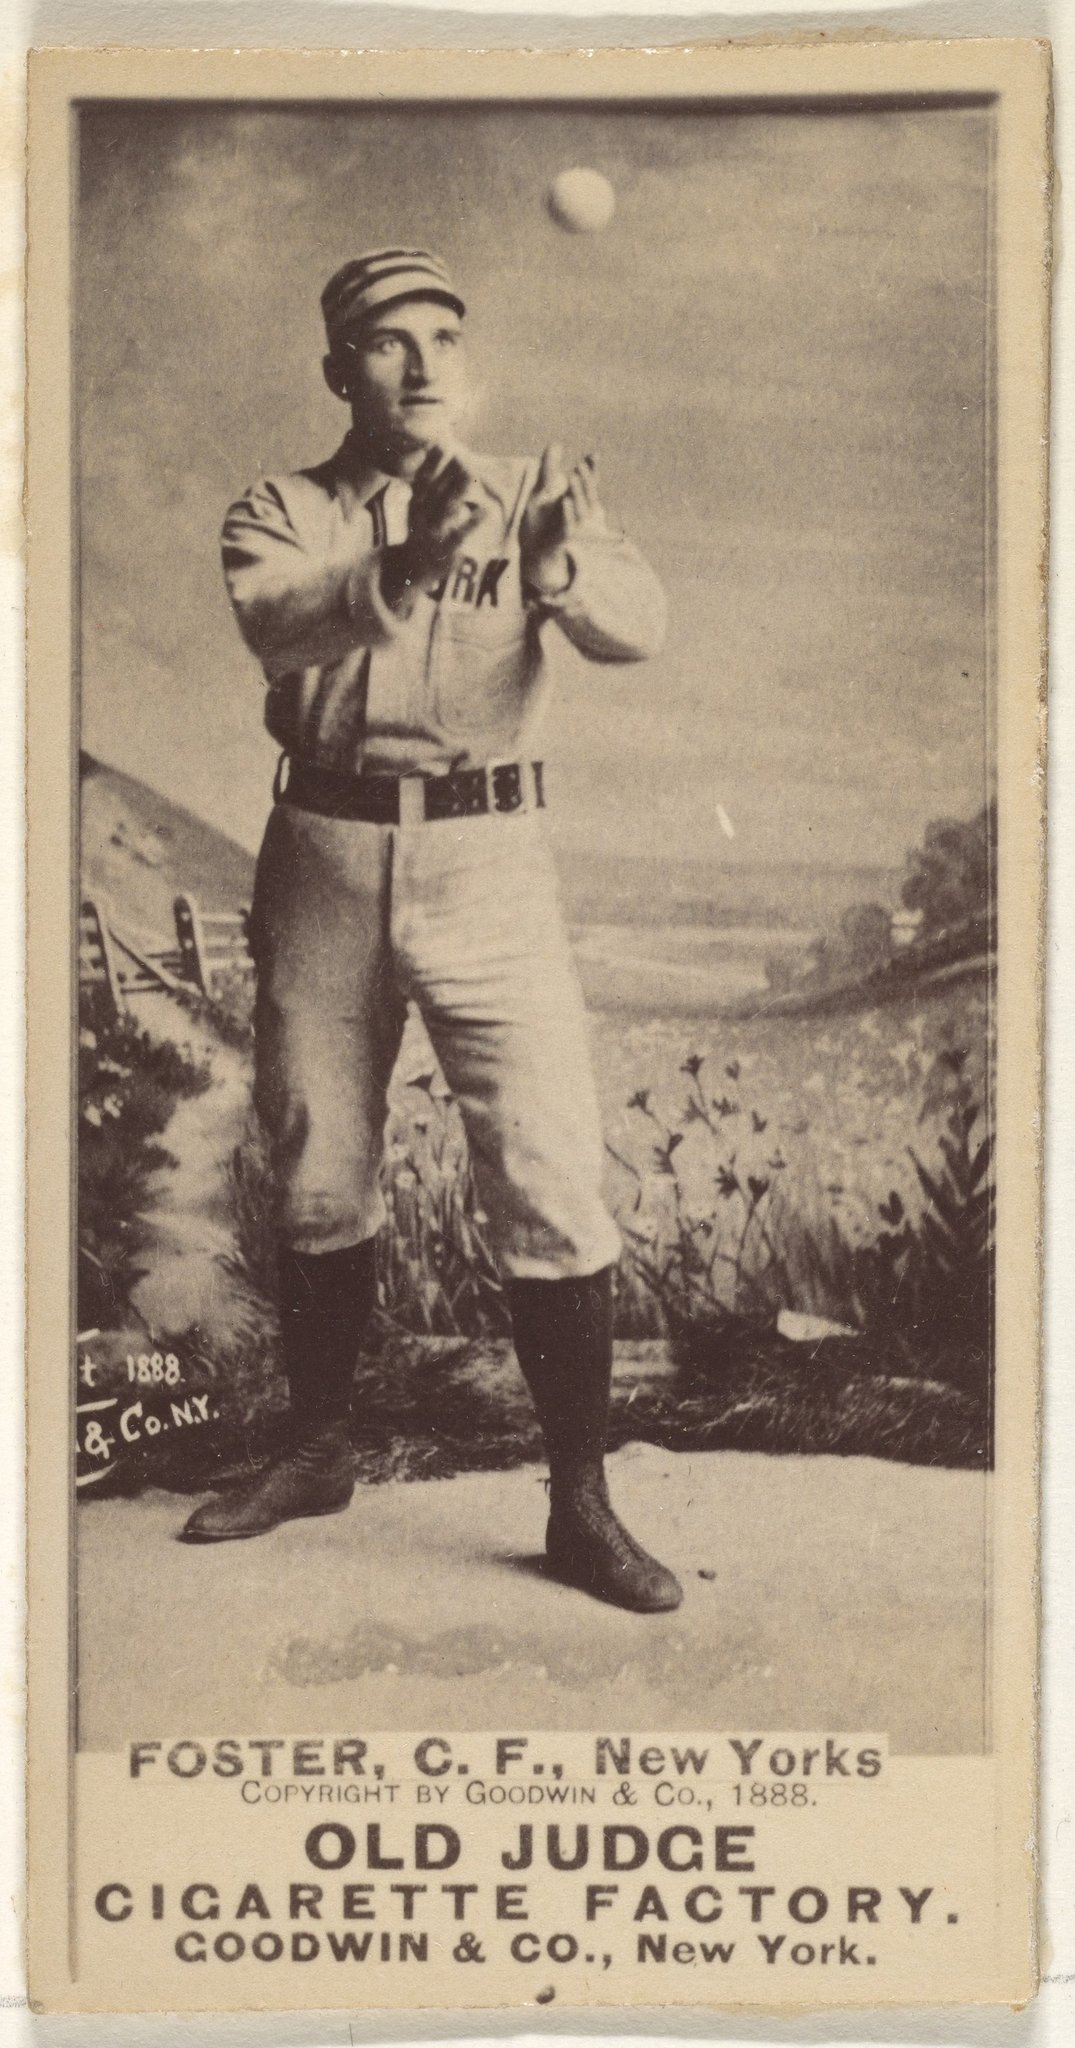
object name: baseball card, photograph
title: Elmer Ellsworth Foster, Center Field, New York, from the Old Judge series (N172) for Old Judge Cigarettes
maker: goodwin & company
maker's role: publisher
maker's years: 1850-1950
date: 1888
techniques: albumen silver print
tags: men,portraits,baseball,athletes